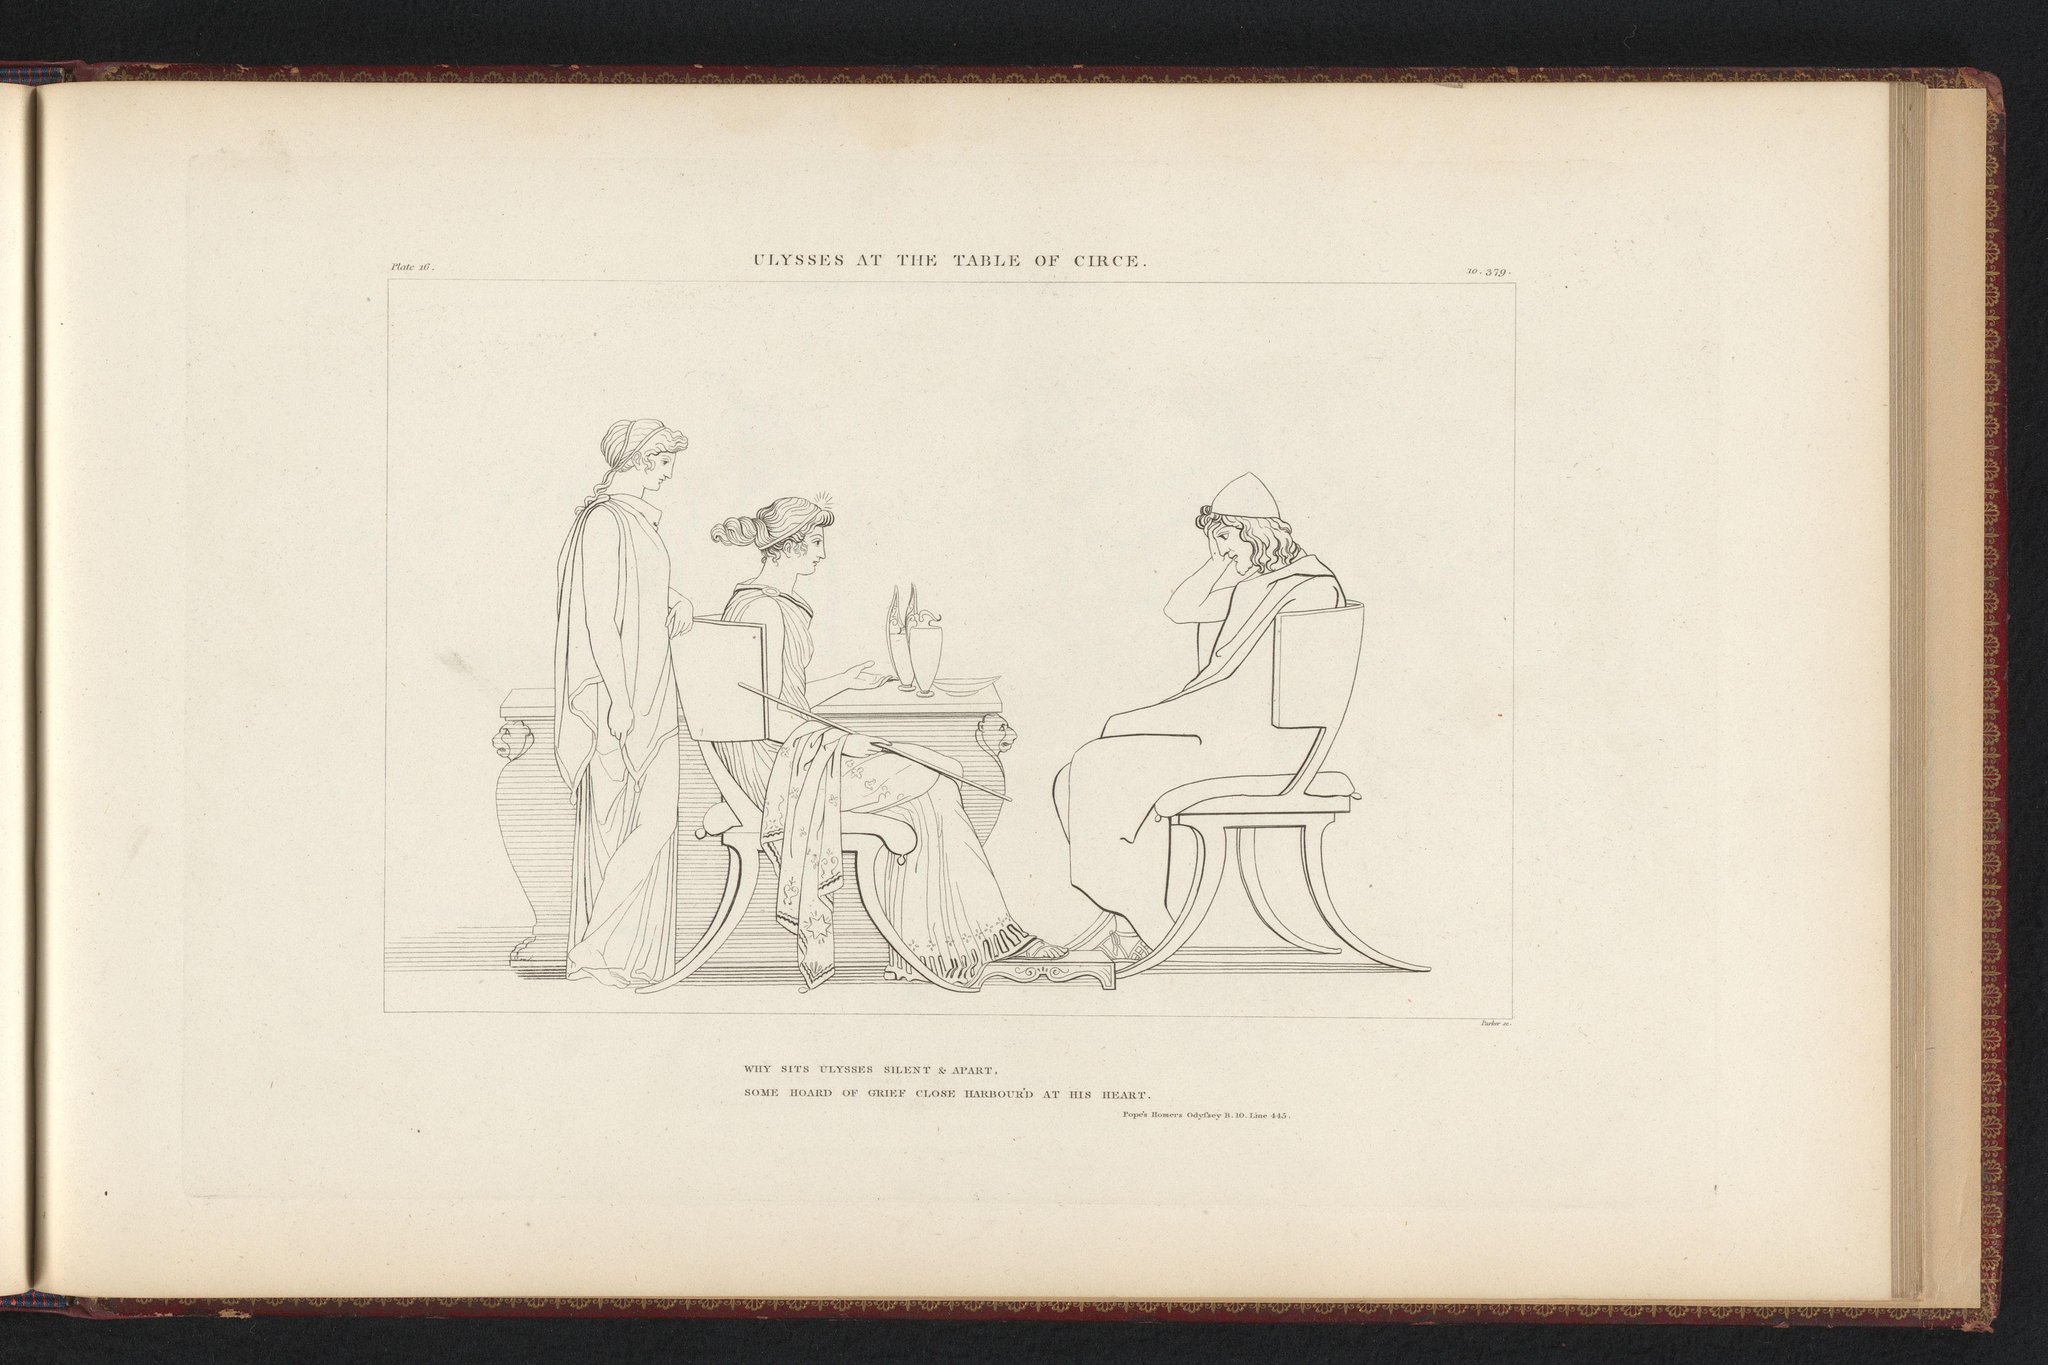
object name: album leaf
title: Odyssee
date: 1805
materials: paper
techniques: etching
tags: ulysses on the island of circe (homer, odyssey x)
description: Prent maakt onderdeel uit van een serie met 34 prenten over de Odyssee, geschreven door Homerus.